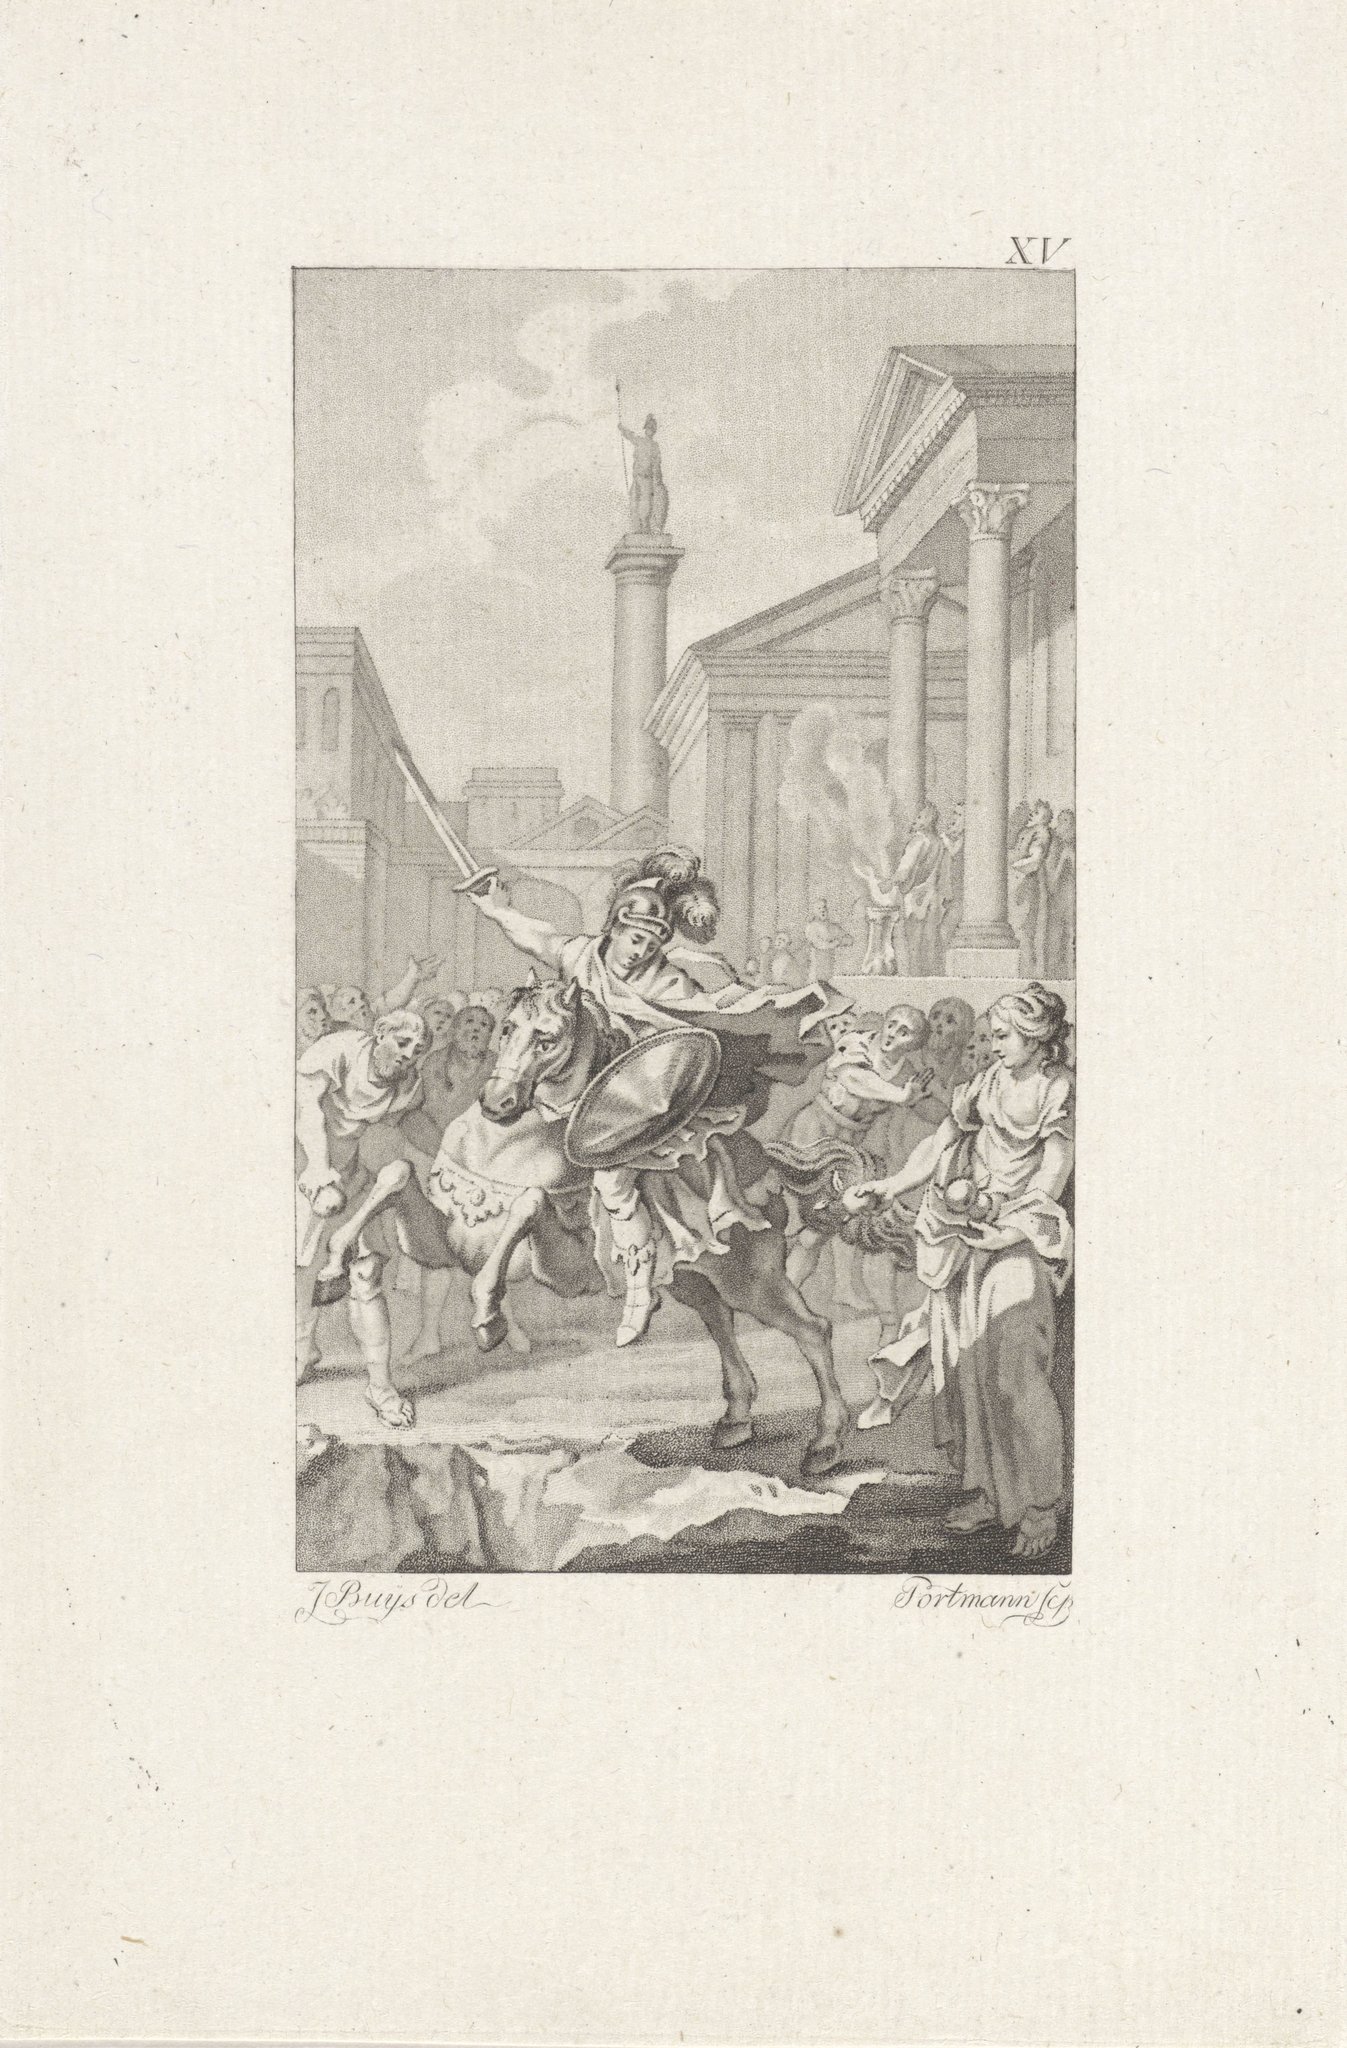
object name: book illustration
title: Zelfopoffering van Marcus Curtius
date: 1794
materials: paper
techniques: stippled etching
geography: amsterdam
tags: death, i.e. the self-sacrifice of marcus (manlius) curtius: he leaps on horseback into a chasm with lethal fumes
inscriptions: collector's mark: Lugt 2228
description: De Romeinse held Marcus Curtius stort zich te paard in een kloof, om de goden tevreden te stellen, ten gerieve van het heil van Rome.